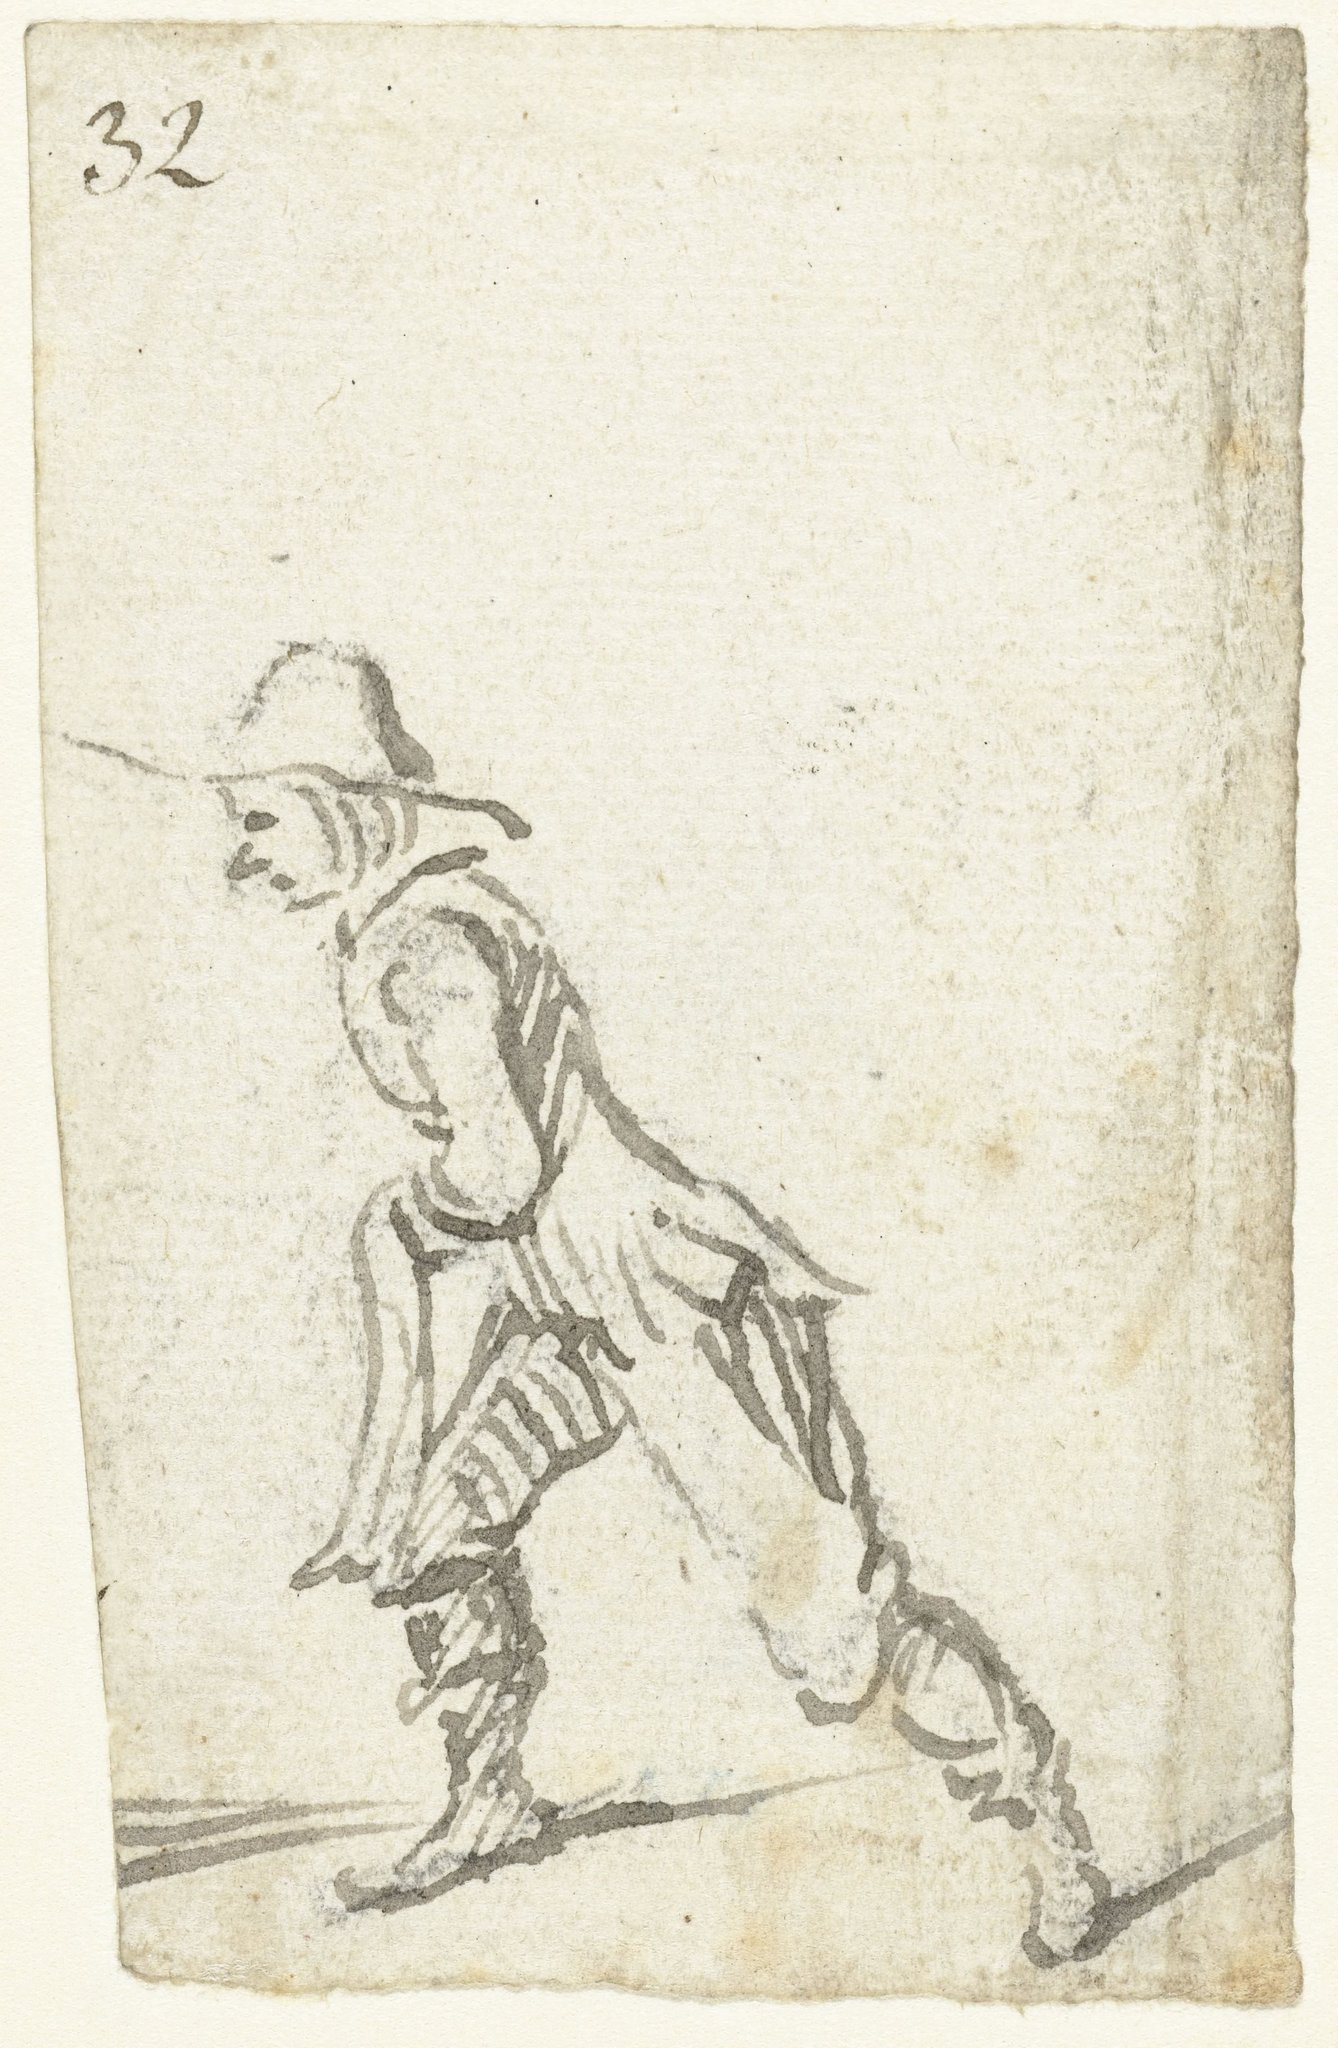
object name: drawing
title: Jongen die een sjerp of sjaal (?) vasthoudt, naar links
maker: harmen ter borch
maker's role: draughtsman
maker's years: 1638-1677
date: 1649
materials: chalk, ink, paper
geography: zwolle